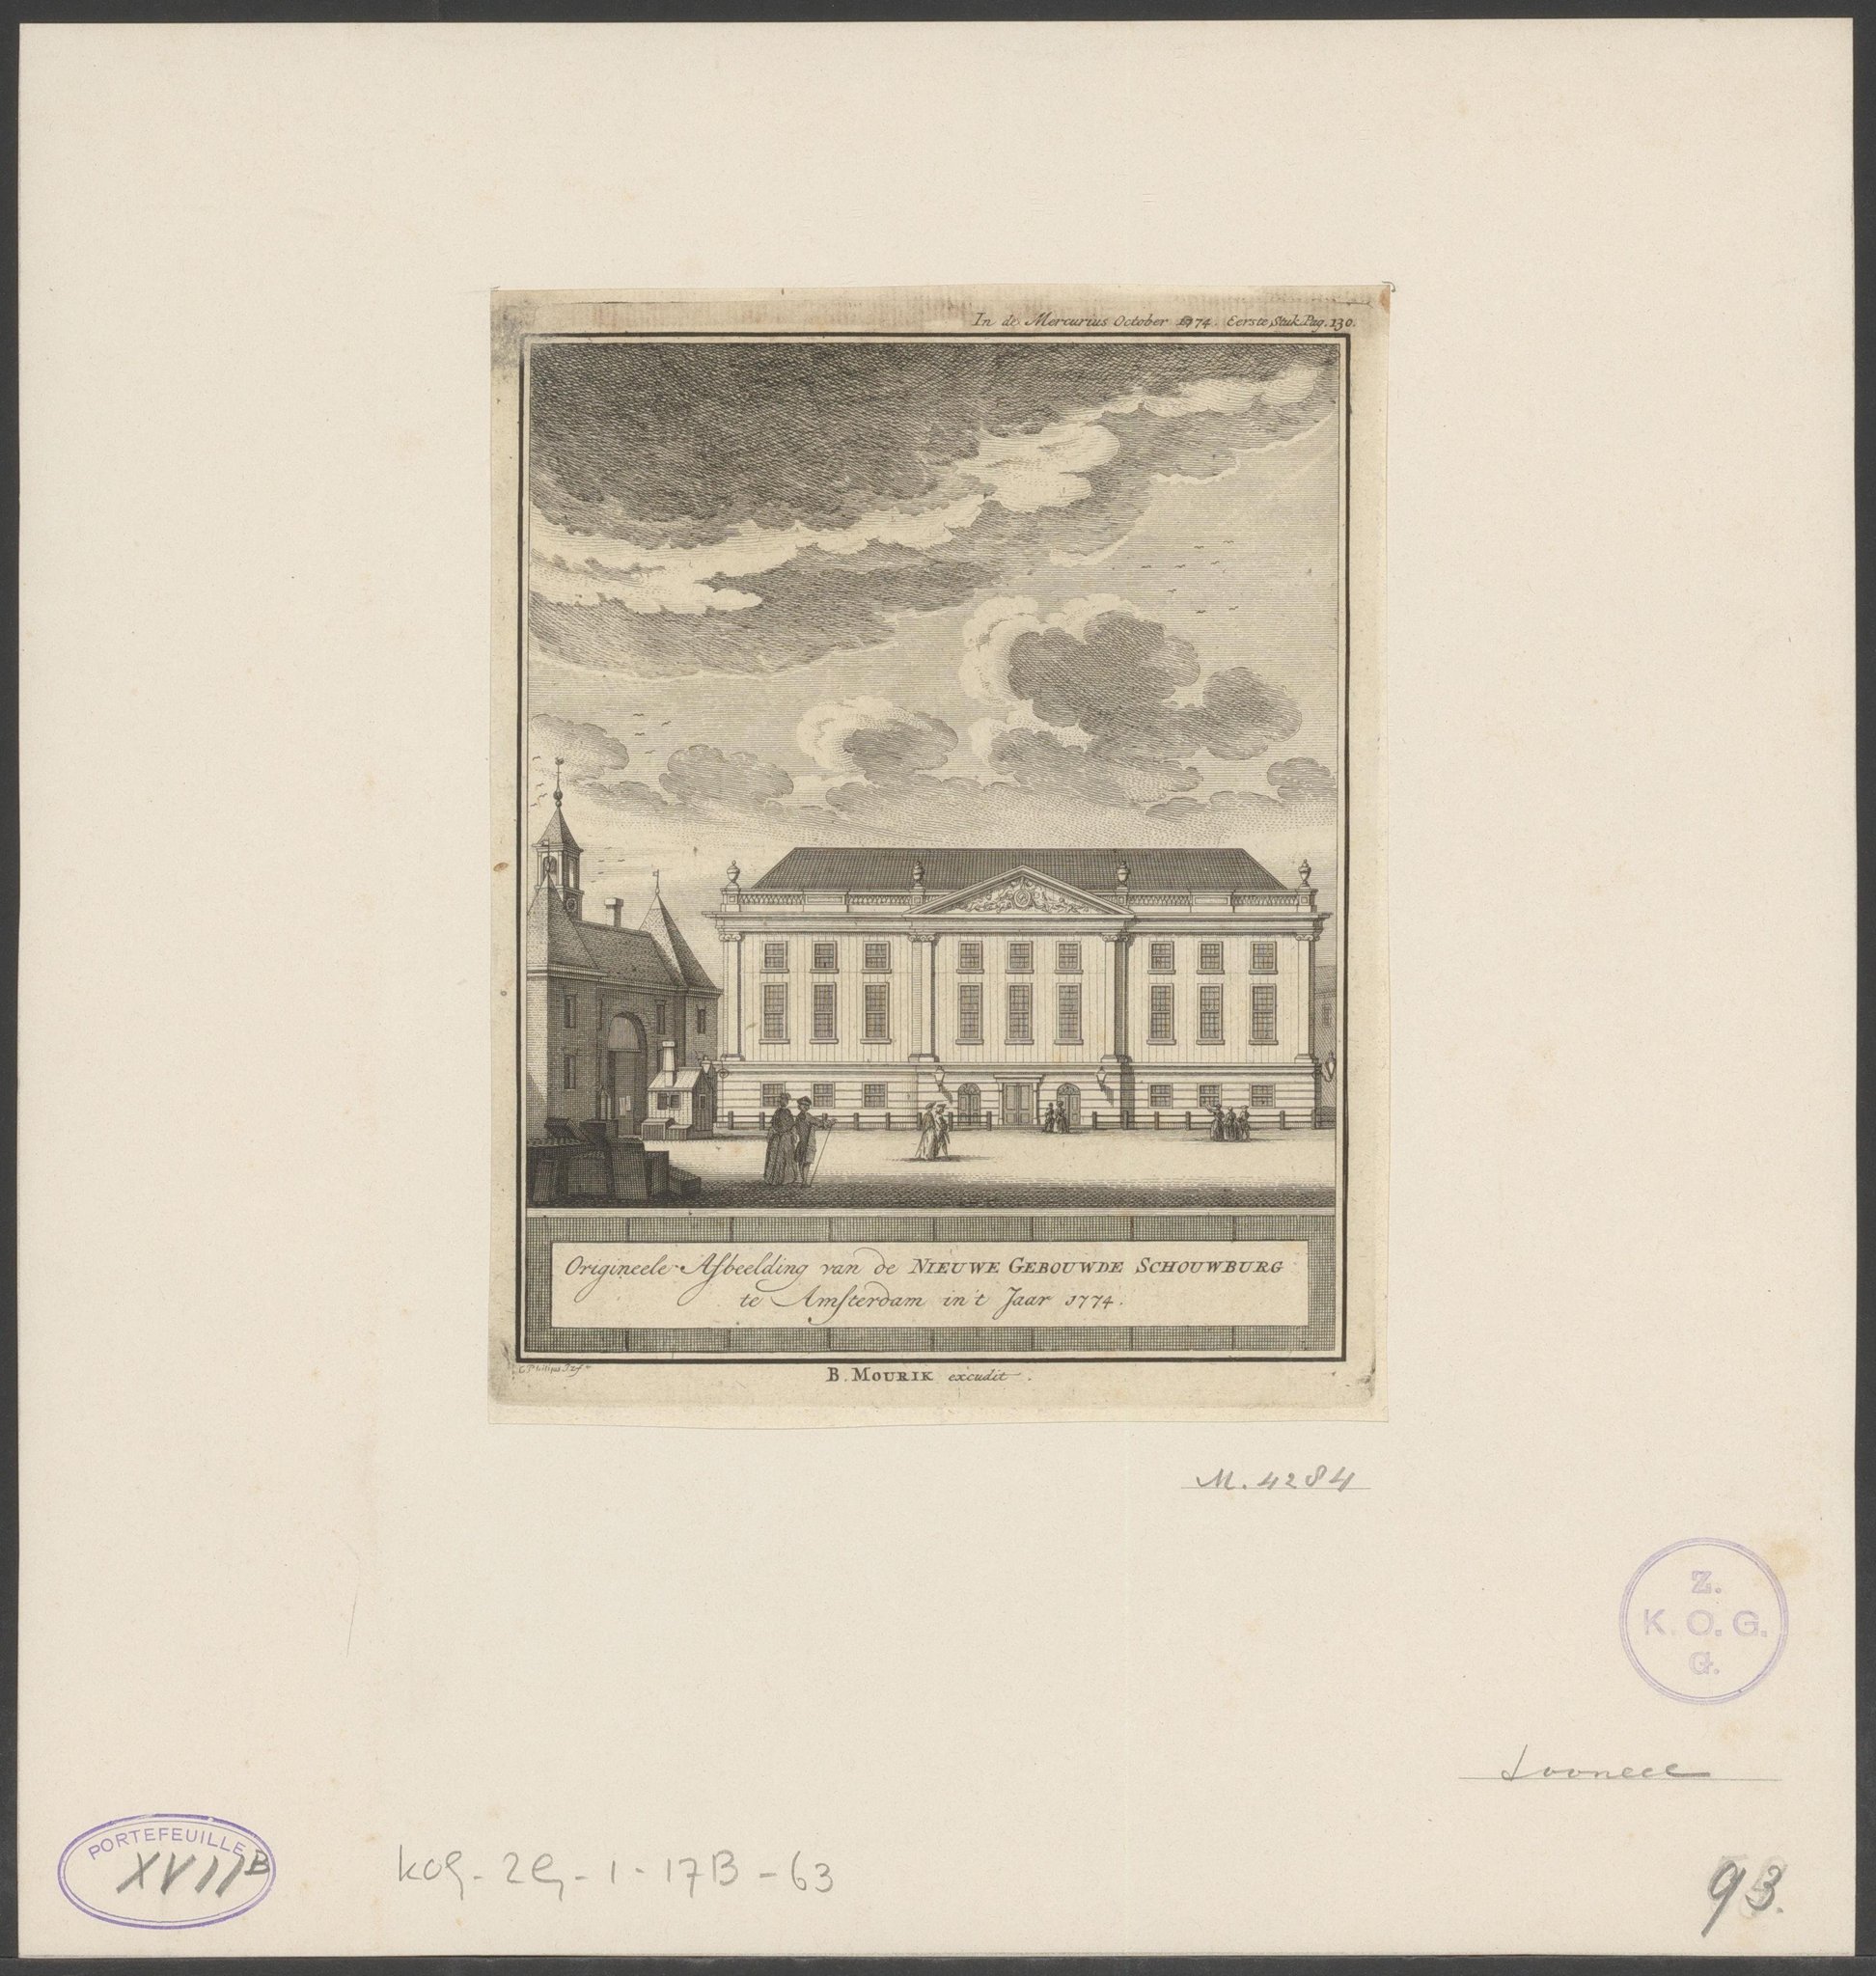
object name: print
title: Origineele Afbeelding van de Nieuwe Gebouwde Schouwburg te Amsterdam in't Jaar 1774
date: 1710-1774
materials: paper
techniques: engraving, etching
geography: amsterdam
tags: theatre (building), city-gate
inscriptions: stamp, collector's mark: Lugt 1641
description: Gezicht op de nieuwe Schouwburg op het Leidseplein te Amsterdam, ingewijd op 15 september 1774. Links de Leidsepoort. Deze stadsschouwburg werd gebouwd om de in 1772 afgebrande schouwburg aan de Keizersgracht te vervangen en brandde in 1890 zelf af. Rechtsboven genummerd: In de Mercurius October 1774. Eerste Stuk Pag. 130. Onderwerpsrubrieken binnen de Atlas Zeden en Gewoonten: Schoone kunsten, Tooneel, Schouwburg op het Leidscheplein (sedert 1774).